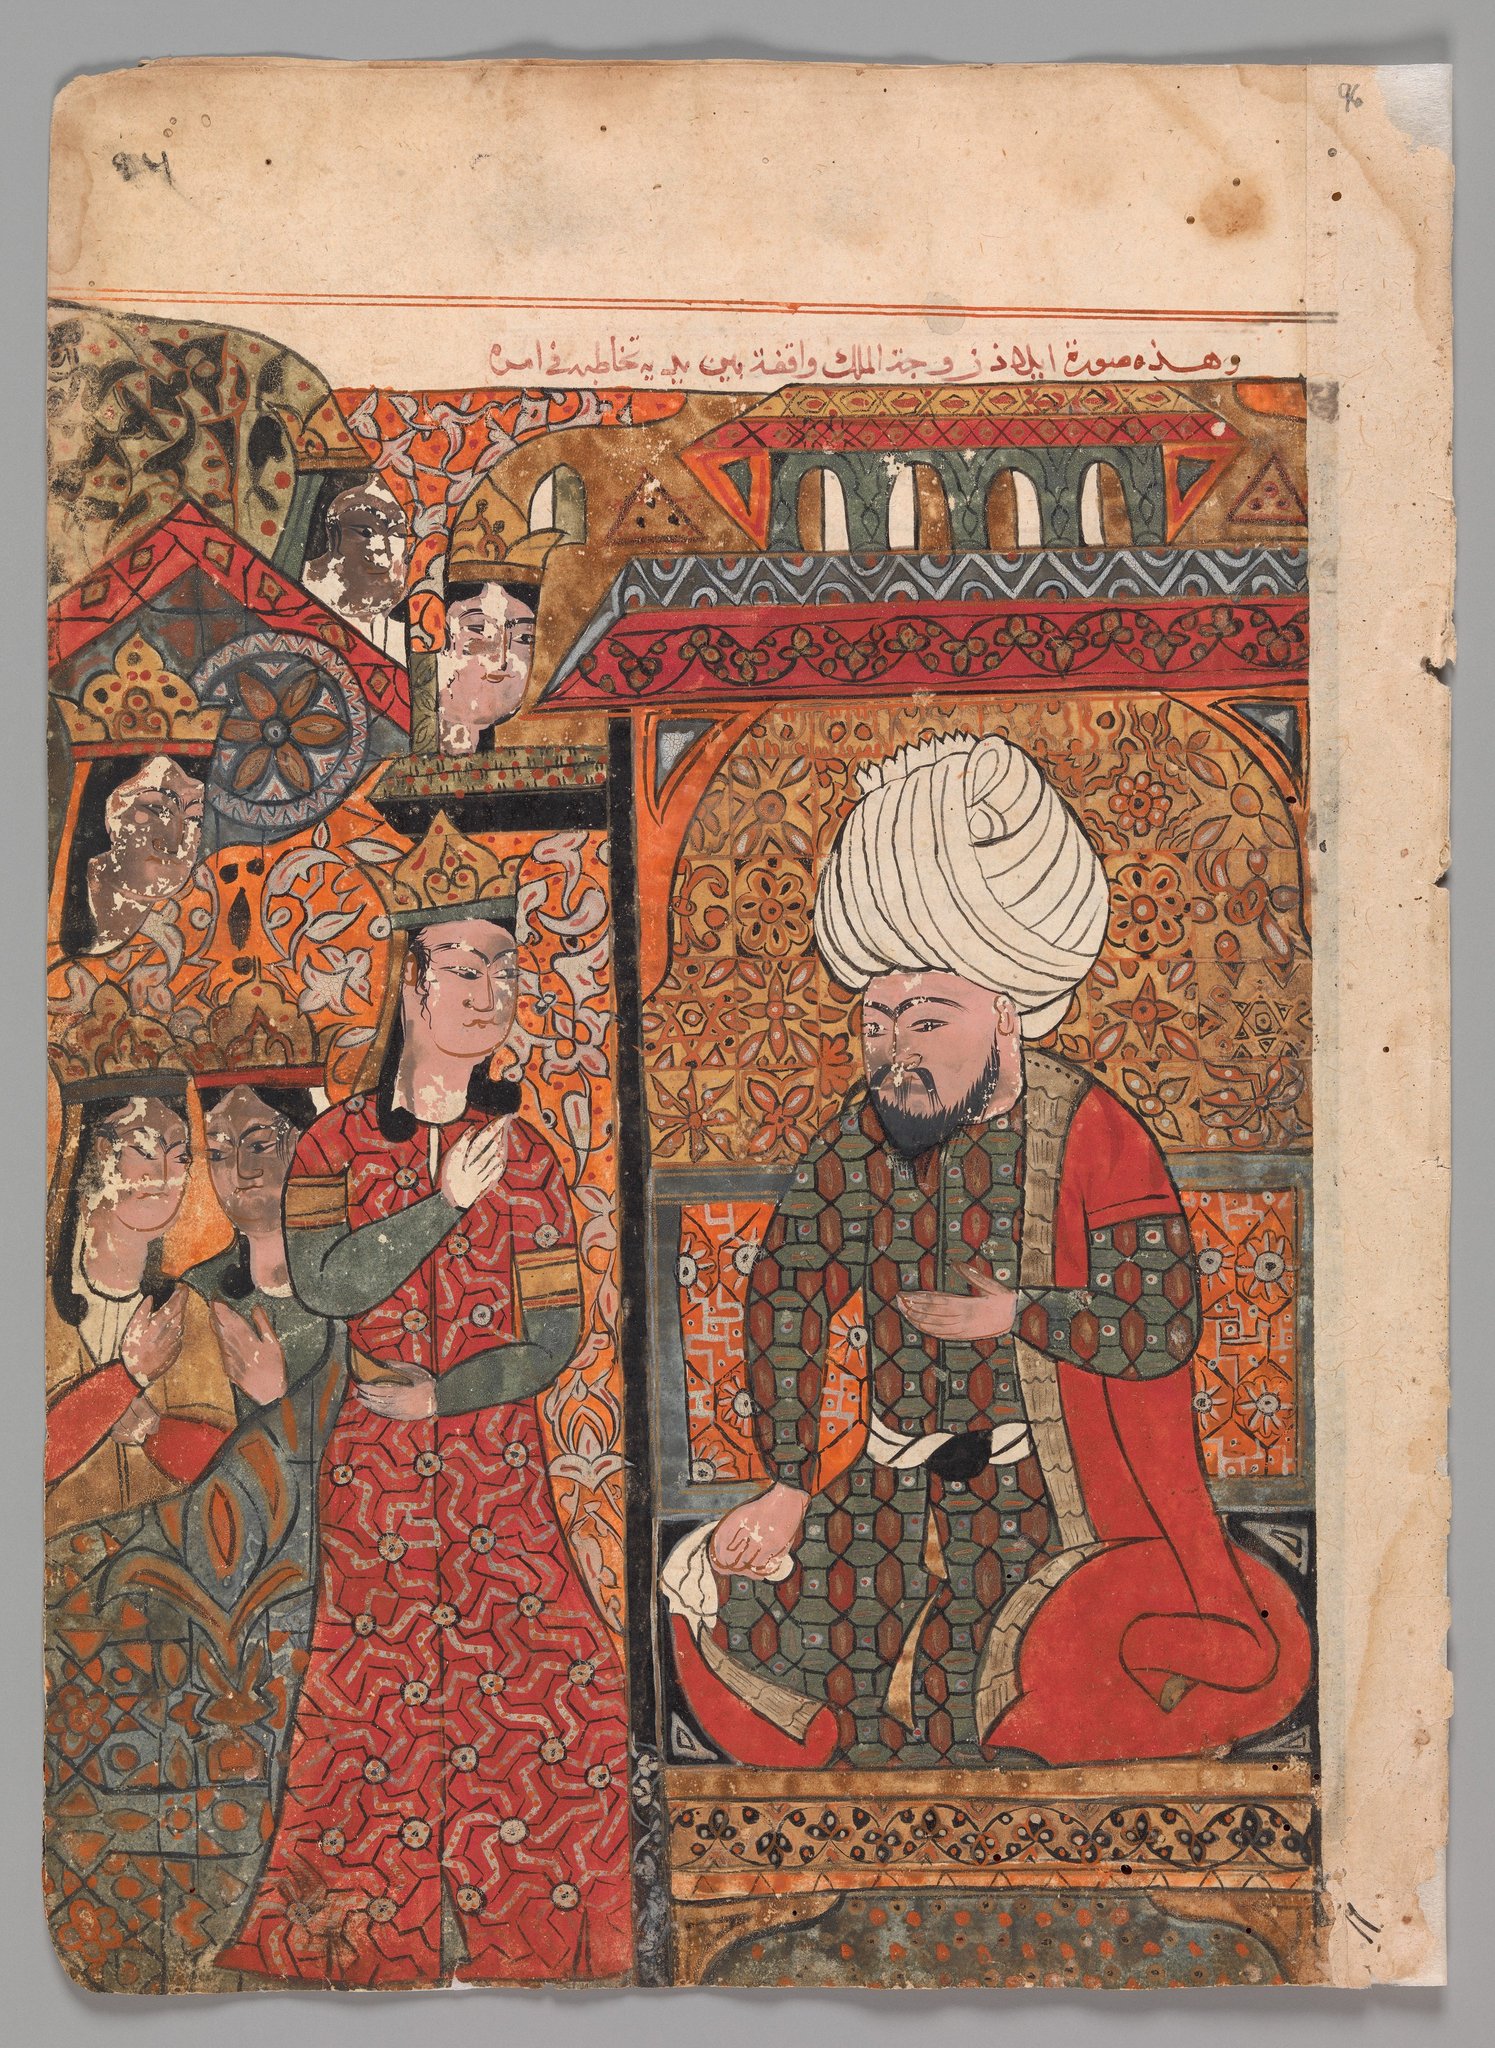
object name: folio from an illustrated manuscript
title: "The Queen Ilar (Irakht) Before the King Warning him About the Brahmins (?)", Folio from a Kalila wa Dimna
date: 1526-1550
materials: ink, paper, watercolor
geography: india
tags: kings,queens,women